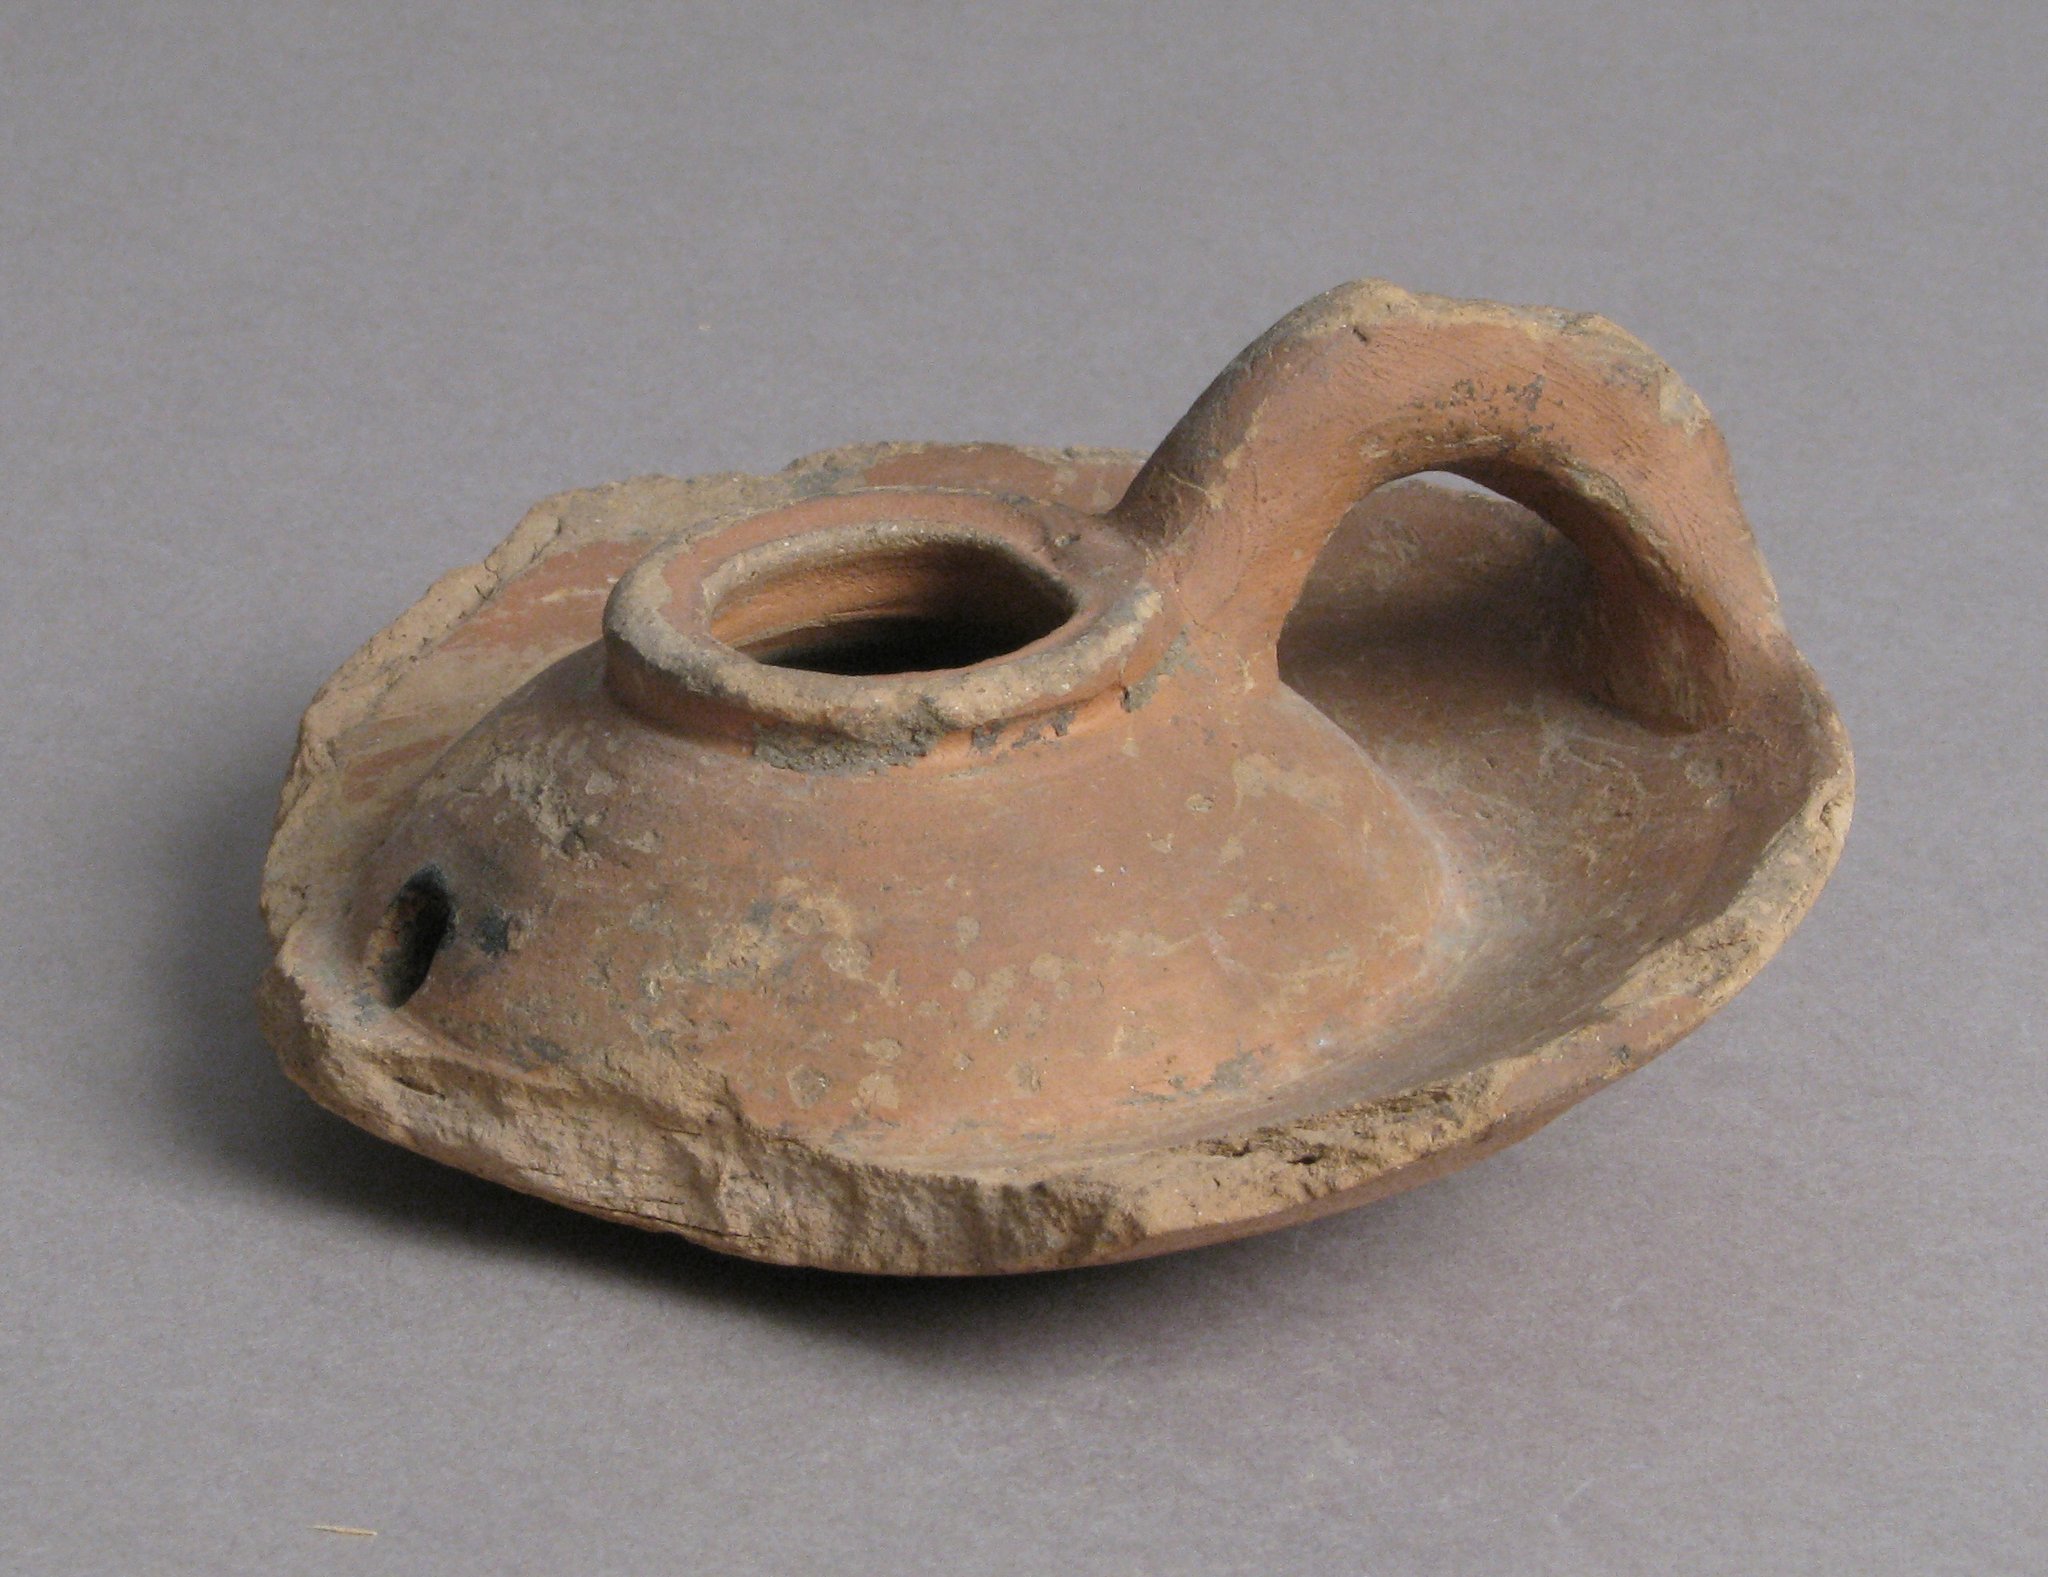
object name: lamp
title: Oil Lamp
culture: coptic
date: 301-700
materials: earthenware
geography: egypt